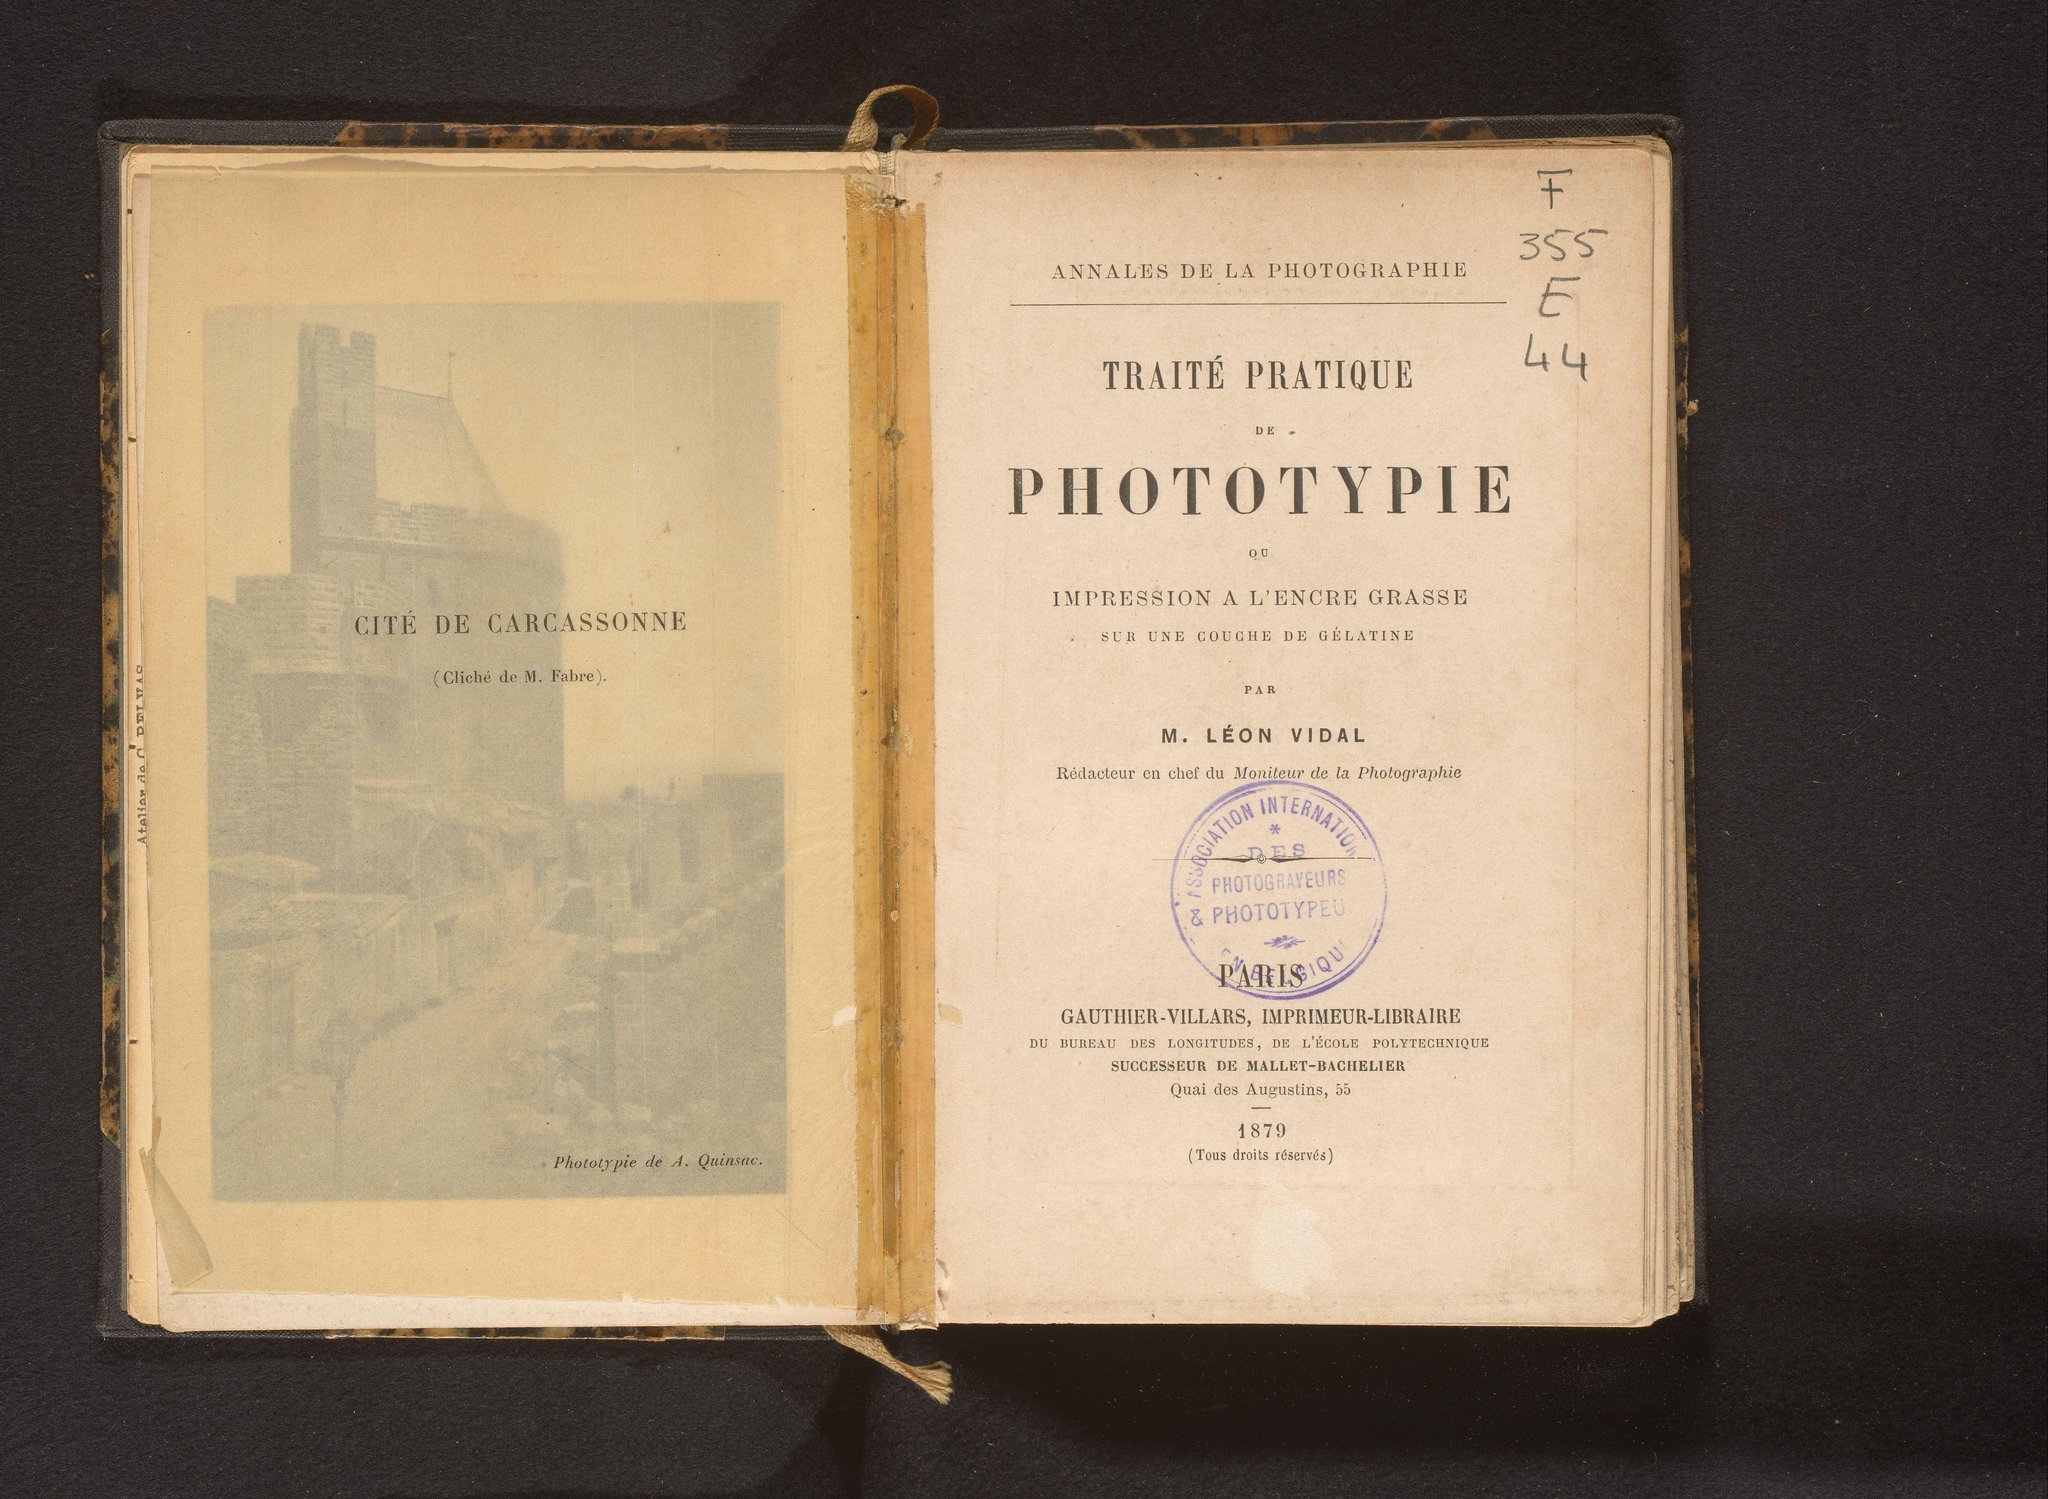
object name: book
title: Traité pratique de phototypie ou impression à l'encre grasse sur une couche de gélatine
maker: léon vidal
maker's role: fotograaf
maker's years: 1833-1906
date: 1879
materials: linen, paper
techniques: marbled paper, photograph, decorated paper, printing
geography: paris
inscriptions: name: ‘Association International des Photograveurs & Phototypeu en Belgique’, name: ‘André Goin Av. F. Ven [...] 8 Bte 72 1070 Brux - 1.522.64.42’